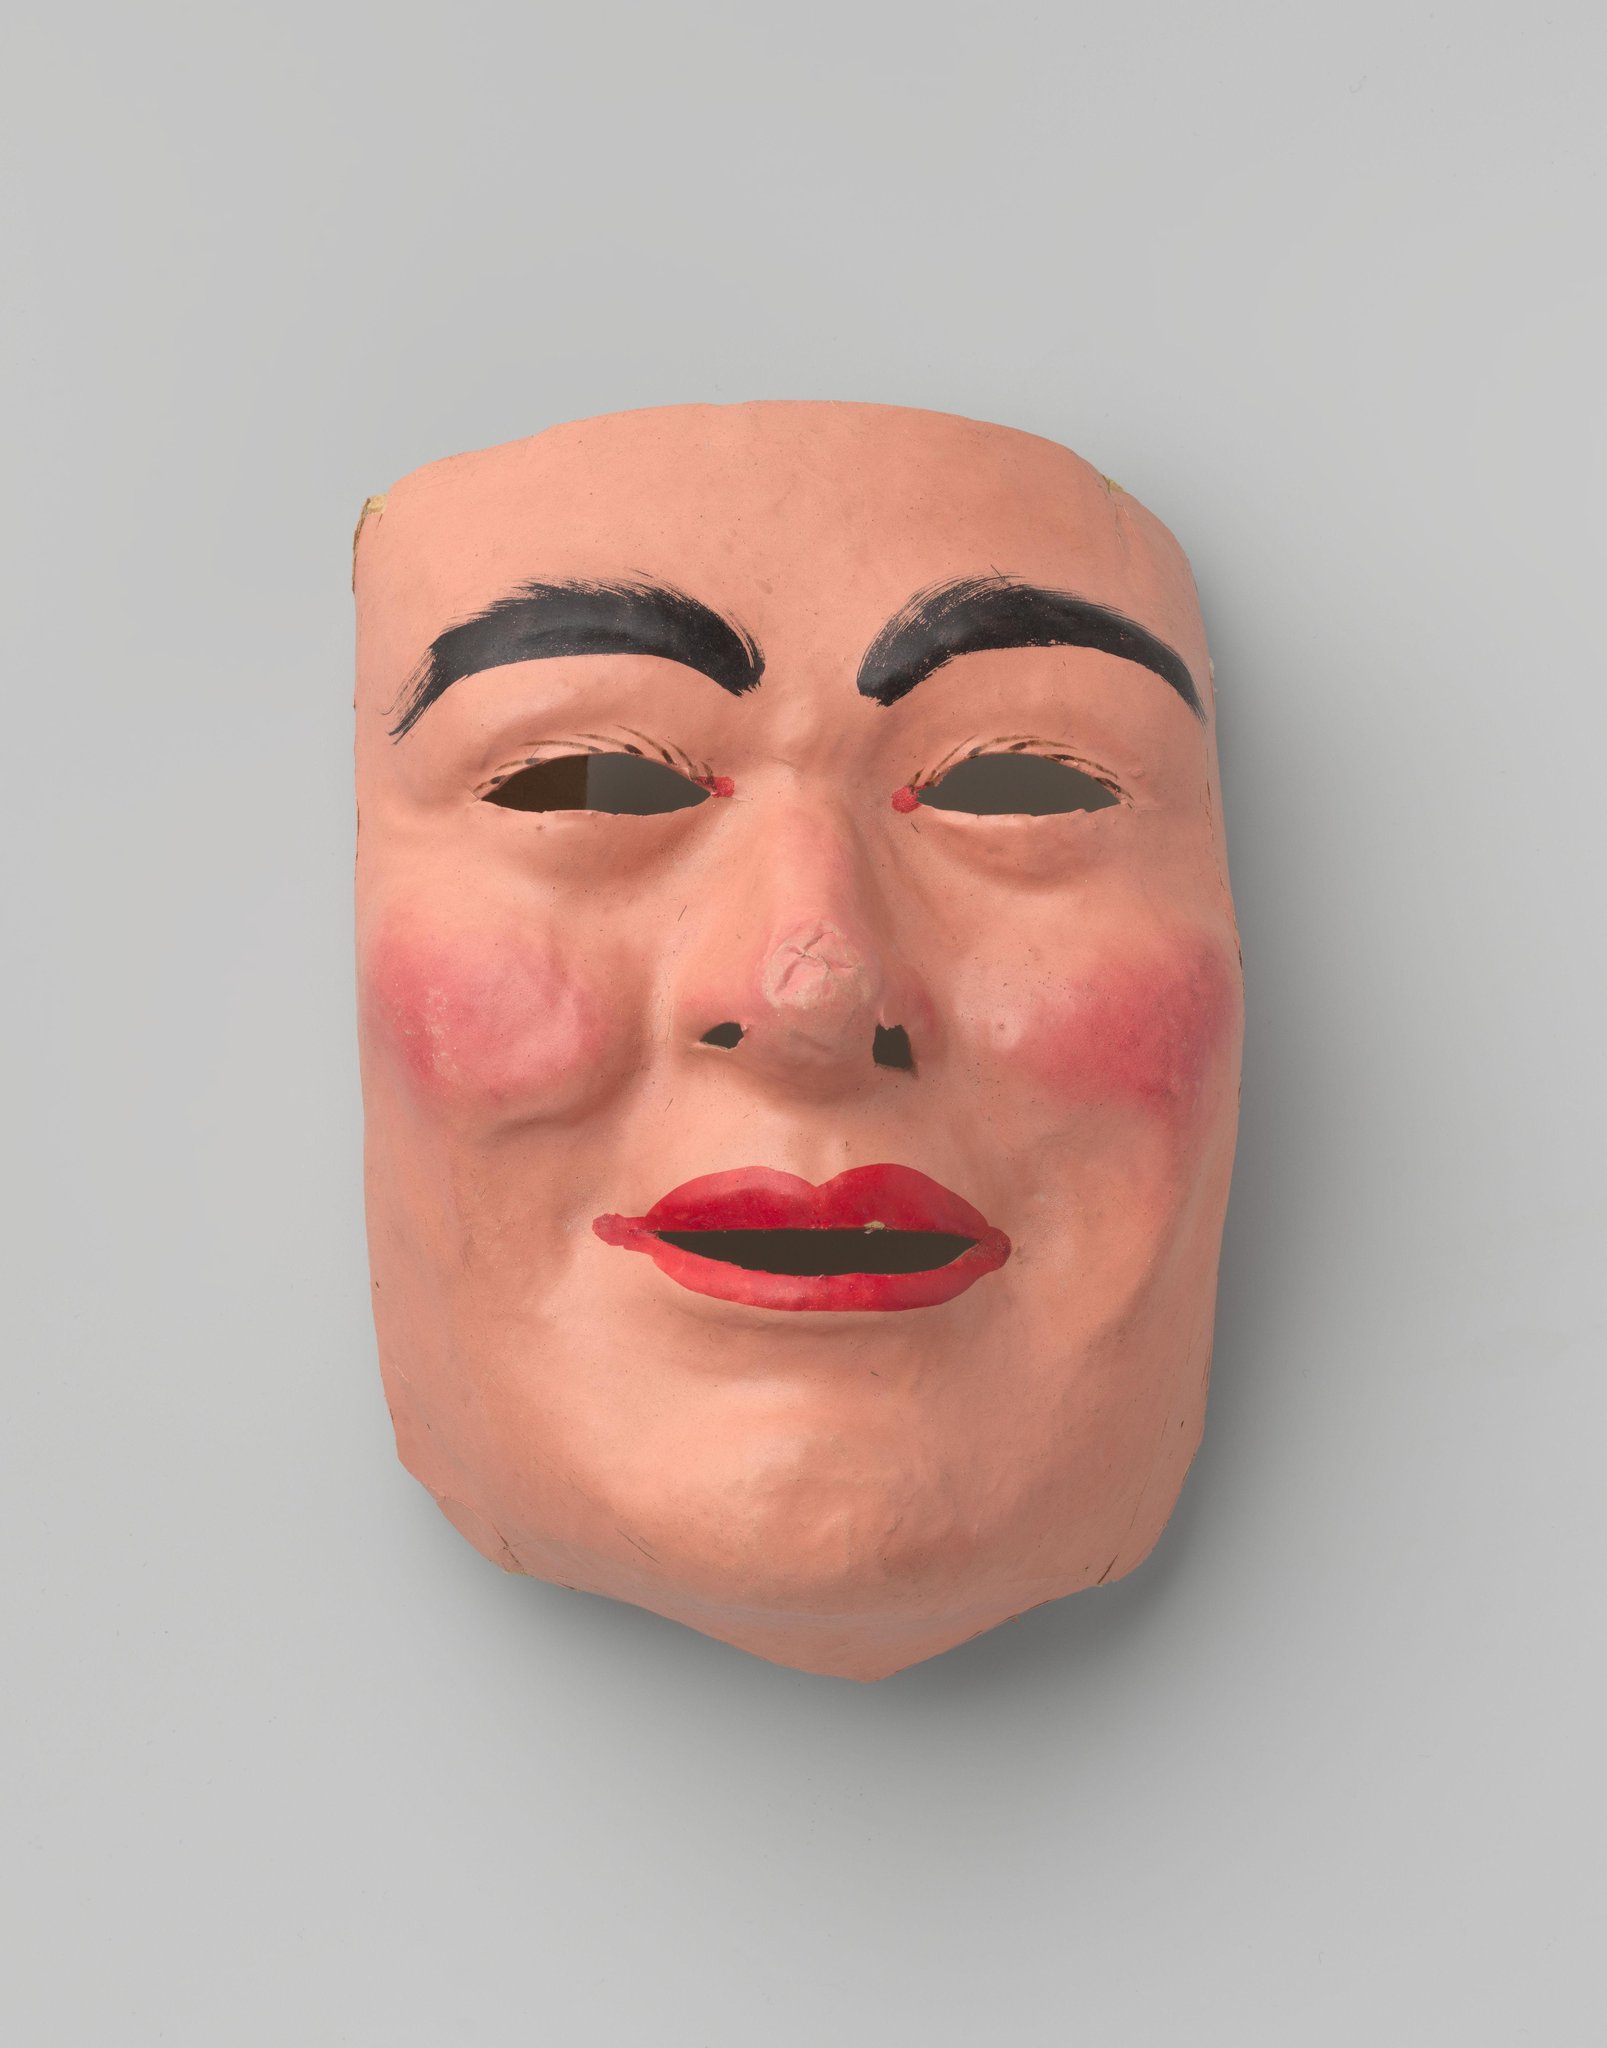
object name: verkleedkleding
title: Masker van beschilderd karton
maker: Anonymous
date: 1840-1900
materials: cardboard, paint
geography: europe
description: Bij de Japonsche rock werd een doos met de volgende inhoud gegeven: zijden jasje, roodfluwelen slippers met zilverdraad geborduurd, een masker en een mijter van papier en een staf. Tezamen vormden deze objecten een Sinterklaas-kostuum dat in de 19de eeuw ten huize van familie van de schenkster werd gedragen:' ca. 1875 voor nichtjes van mijn moeder gebruikt. Alles komt uit de familie van mijn overgrootmoeder Krusemann-Stavorinus.'